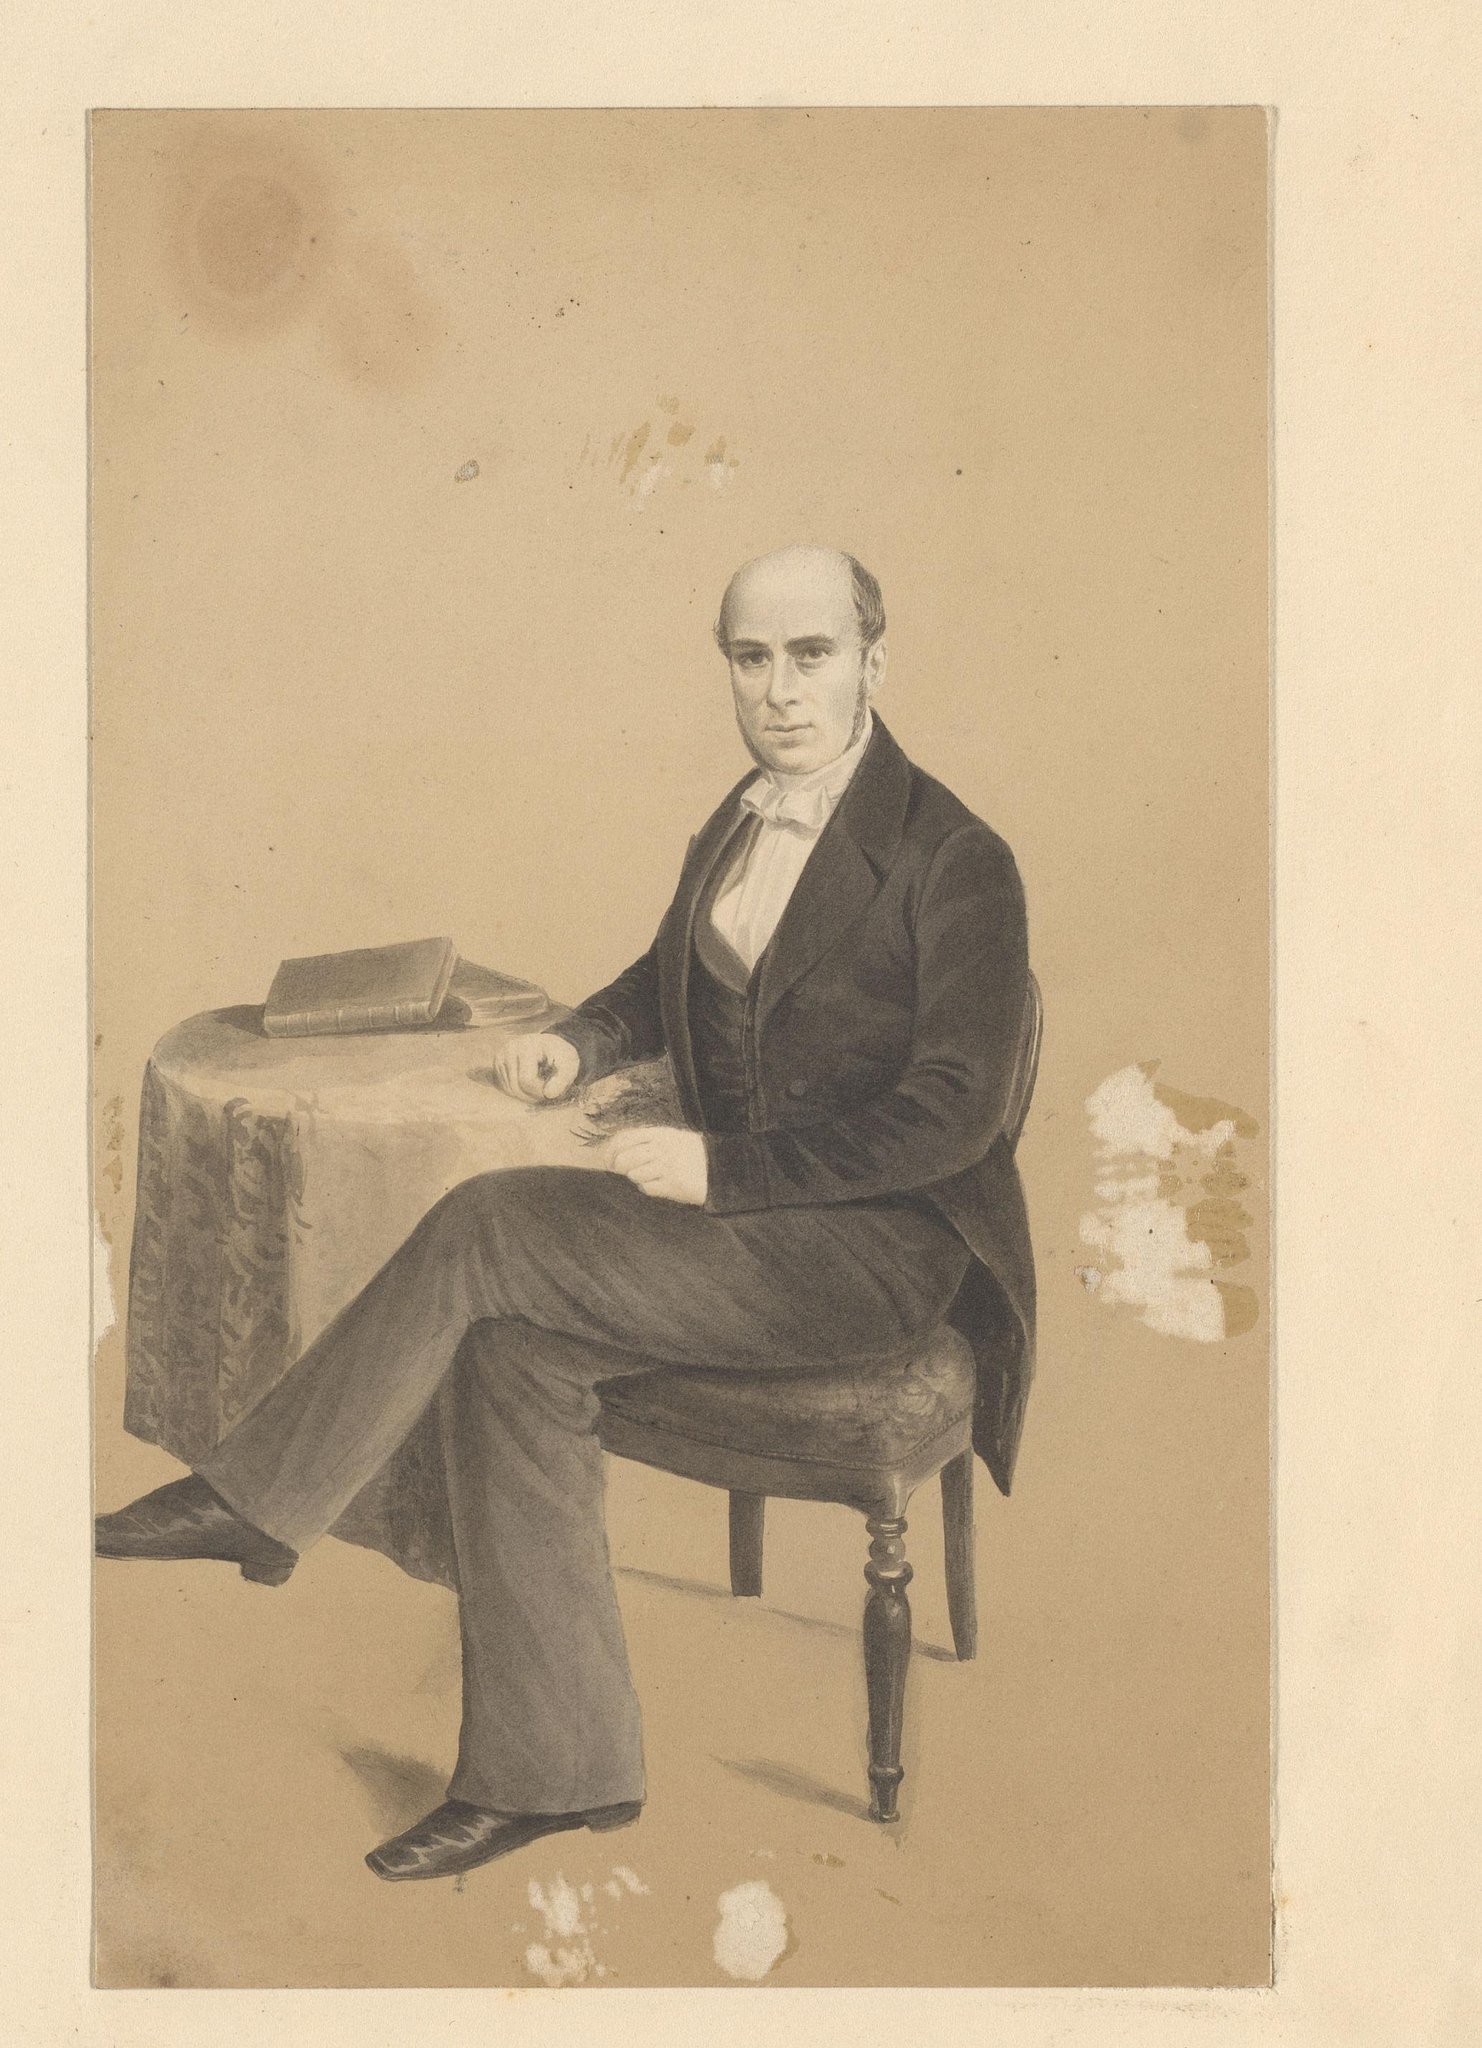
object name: photograph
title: Portret van Eduard Isaac Asser gezeten aan een tafel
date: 1845-1850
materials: paper, photographic support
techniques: salted paper print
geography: netherlands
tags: muntplein (amsterdam), singel, reguliersbreestraat